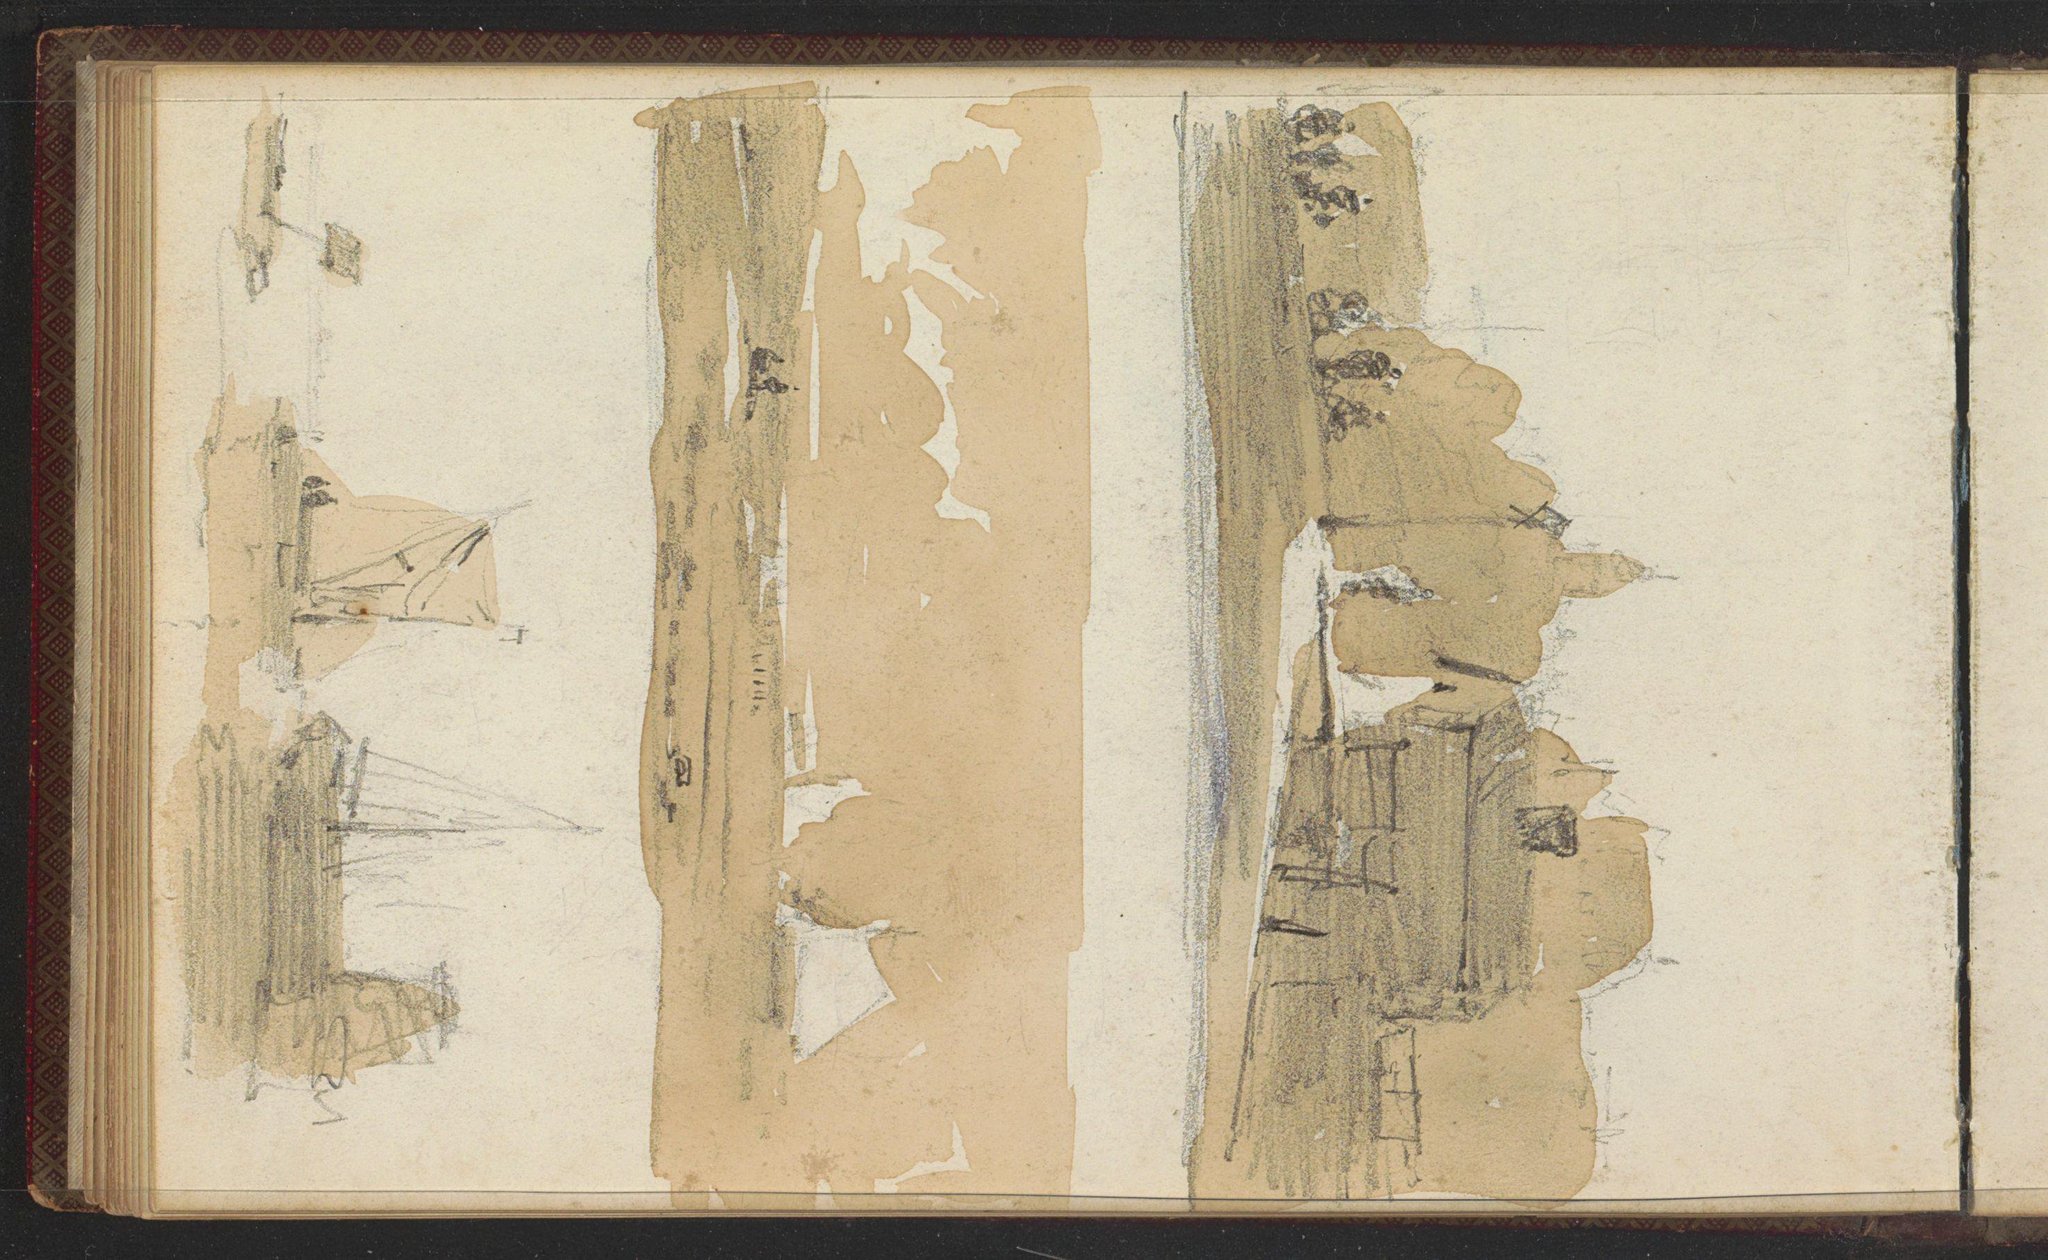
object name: sketchbook leaf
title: Twee landschappen en een stadsgezicht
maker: adrianus eversen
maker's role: draughtsman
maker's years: 1818-1897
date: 1828-1897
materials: paper, pencil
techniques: stumping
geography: netherlands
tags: city-view, and landscape with man-made constructions, sailing-ship, sailing-boat, river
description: Boven een stadsgezicht met vooraan figuren bij een brug. In het midden zeilschepen op open water. Onder ook zeilschepen op open water. Blad 42 verso uit een schetsboek met 52 bladen vervaardigd in de omgeving van Kampen, Hattem, Hoorn en Zwolle.